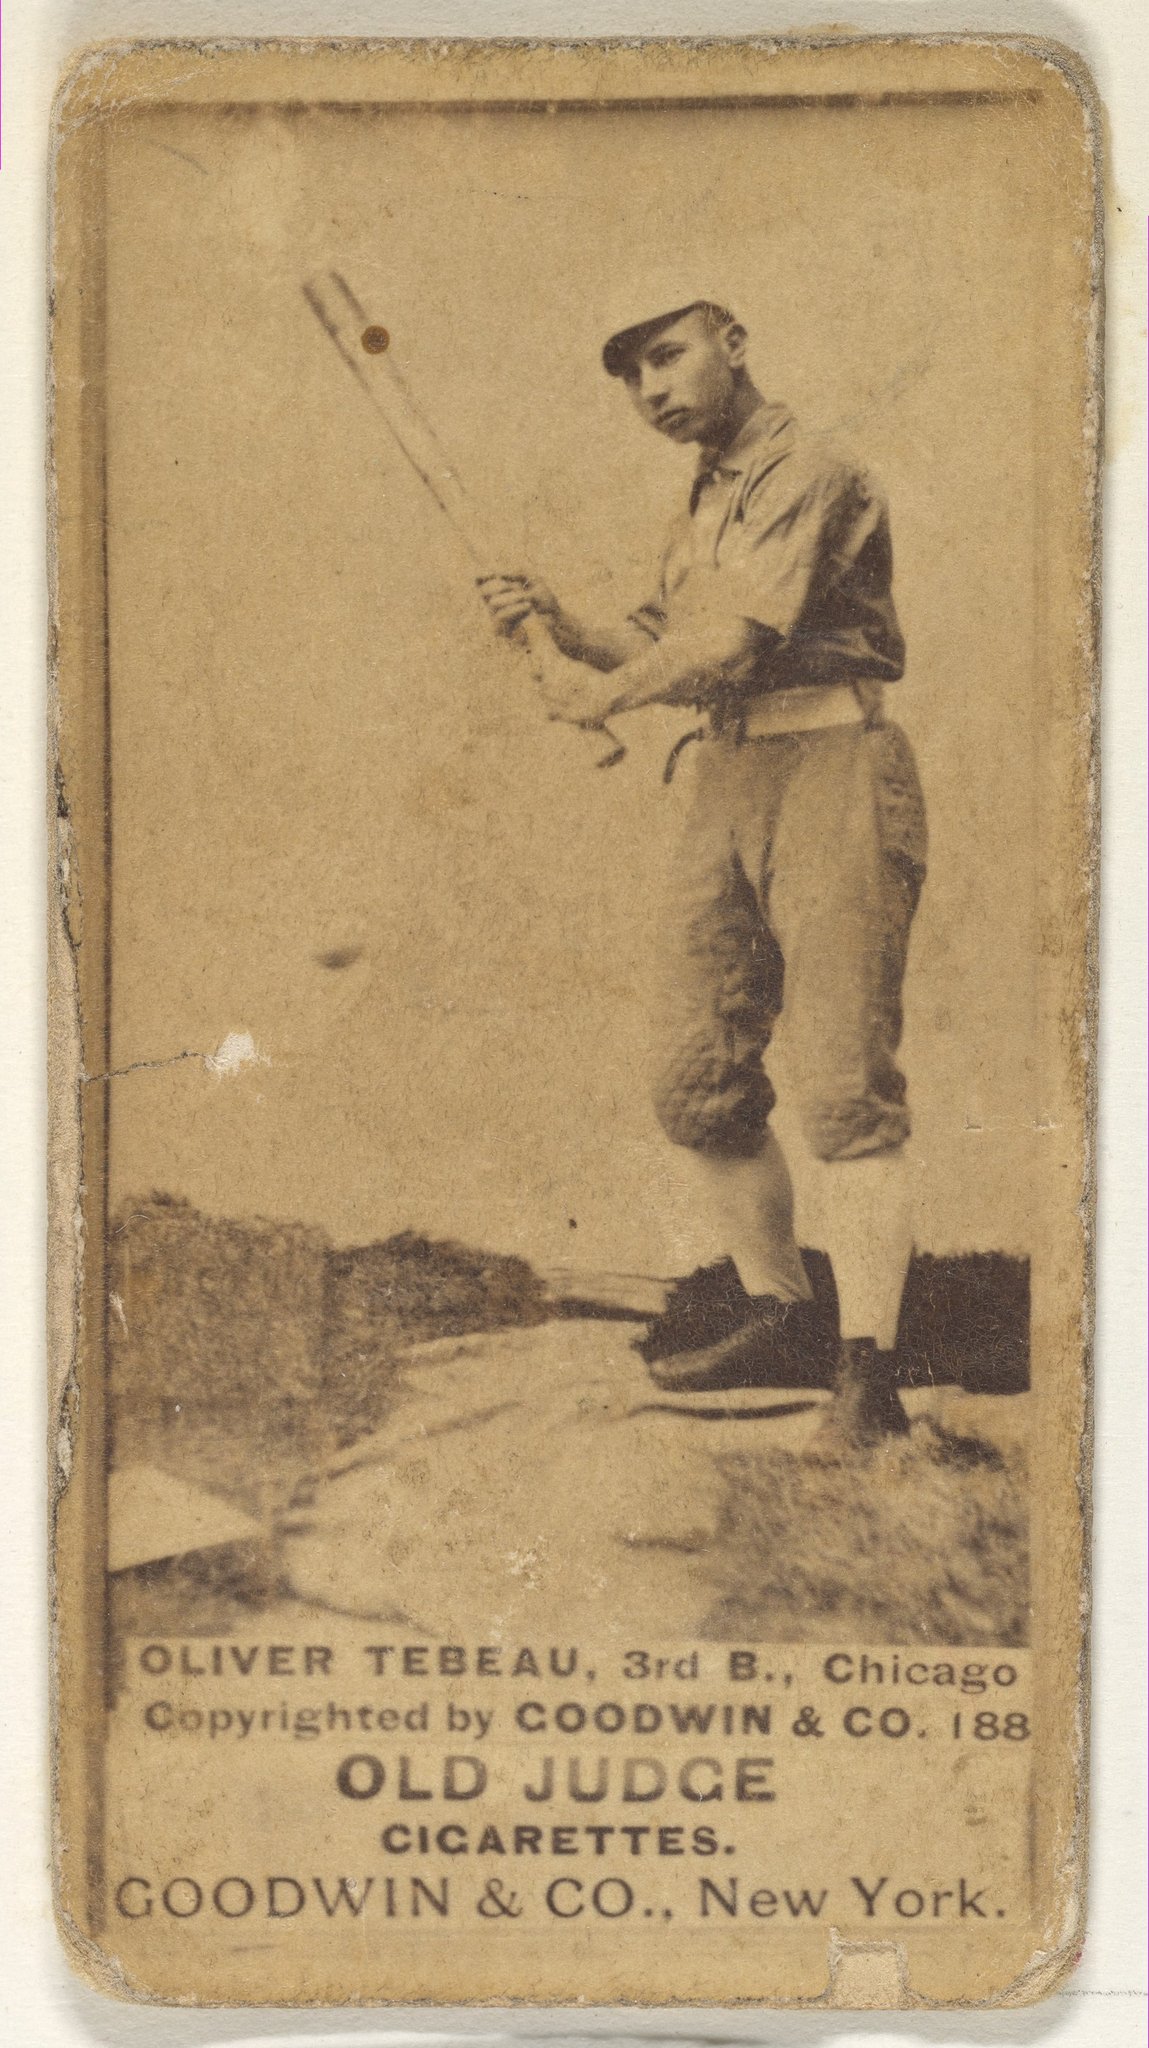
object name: baseball card, photograph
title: Oliver Wendell "Patsy" Tebeau, 3rd Base, Chicago, from the Old Judge series (N172) for Old Judge Cigarettes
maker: goodwin & company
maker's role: publisher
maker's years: 1850-1950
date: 1887-1890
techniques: albumen silver print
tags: men,portraits,baseball,athletes